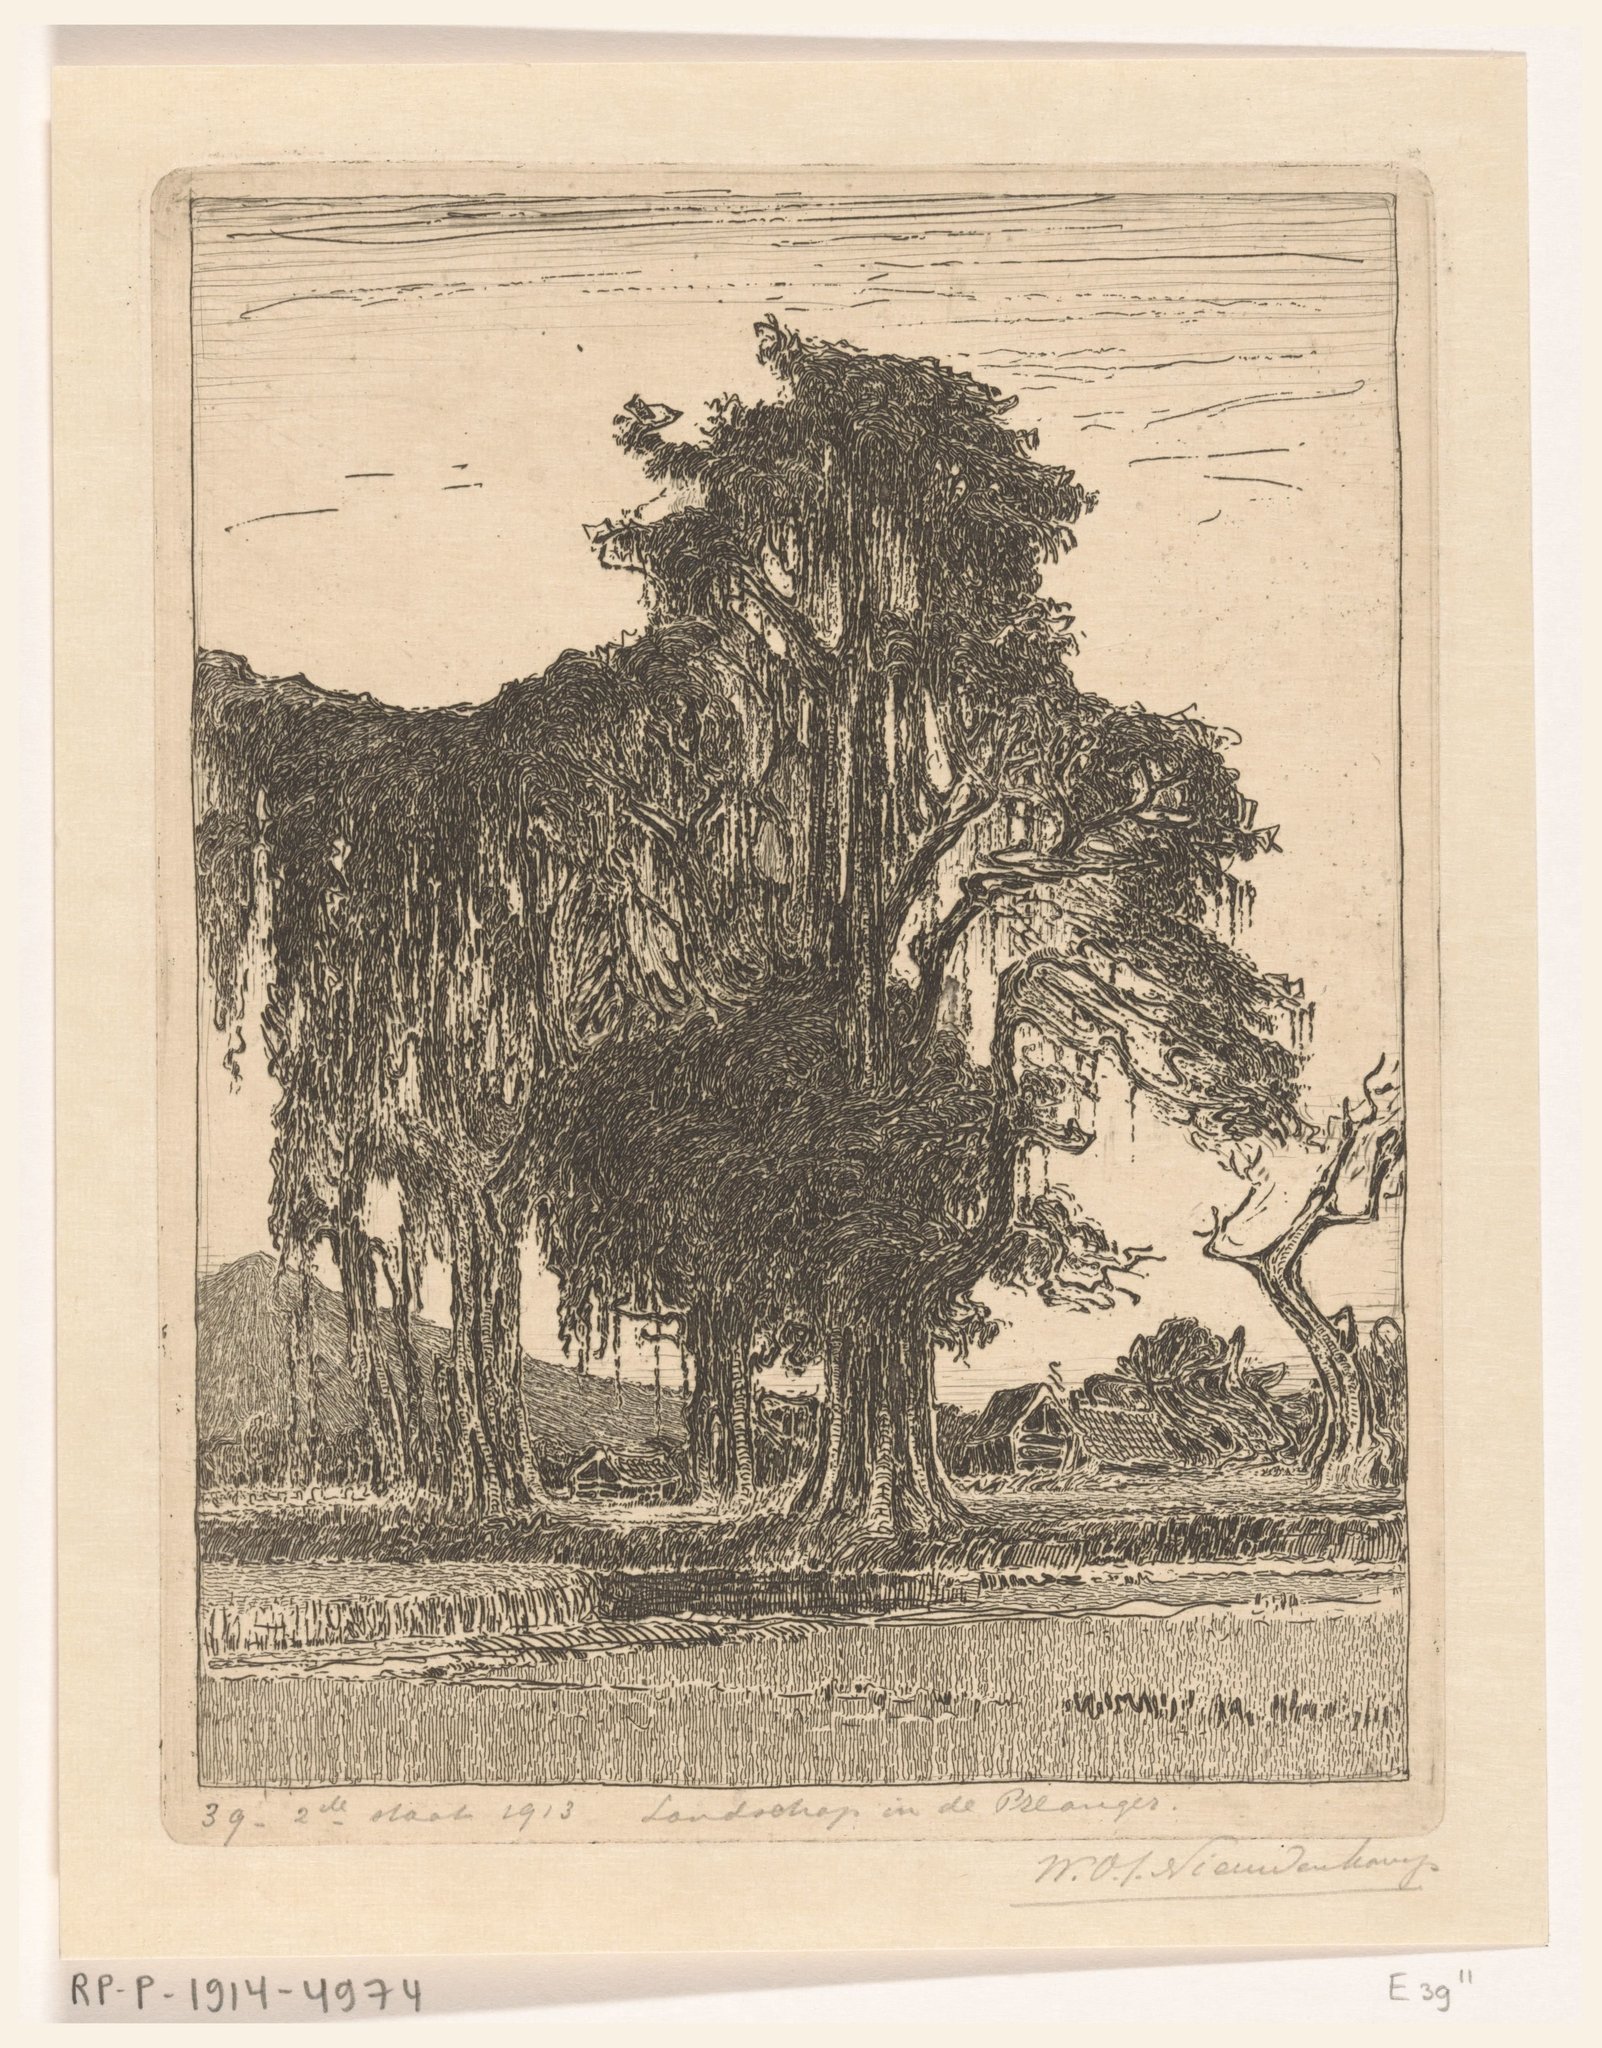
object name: print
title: Landschap in de Preanger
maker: wijnand otto jan nieuwenkamp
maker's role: draughtsman, print maker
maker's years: 1874-1950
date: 1899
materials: paper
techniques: intaglio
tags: trees, mountains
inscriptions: collector's mark: Lugt 2233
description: Op de achtergrond de berg Goenoeng Poetri, nabij de plaats Garoet.